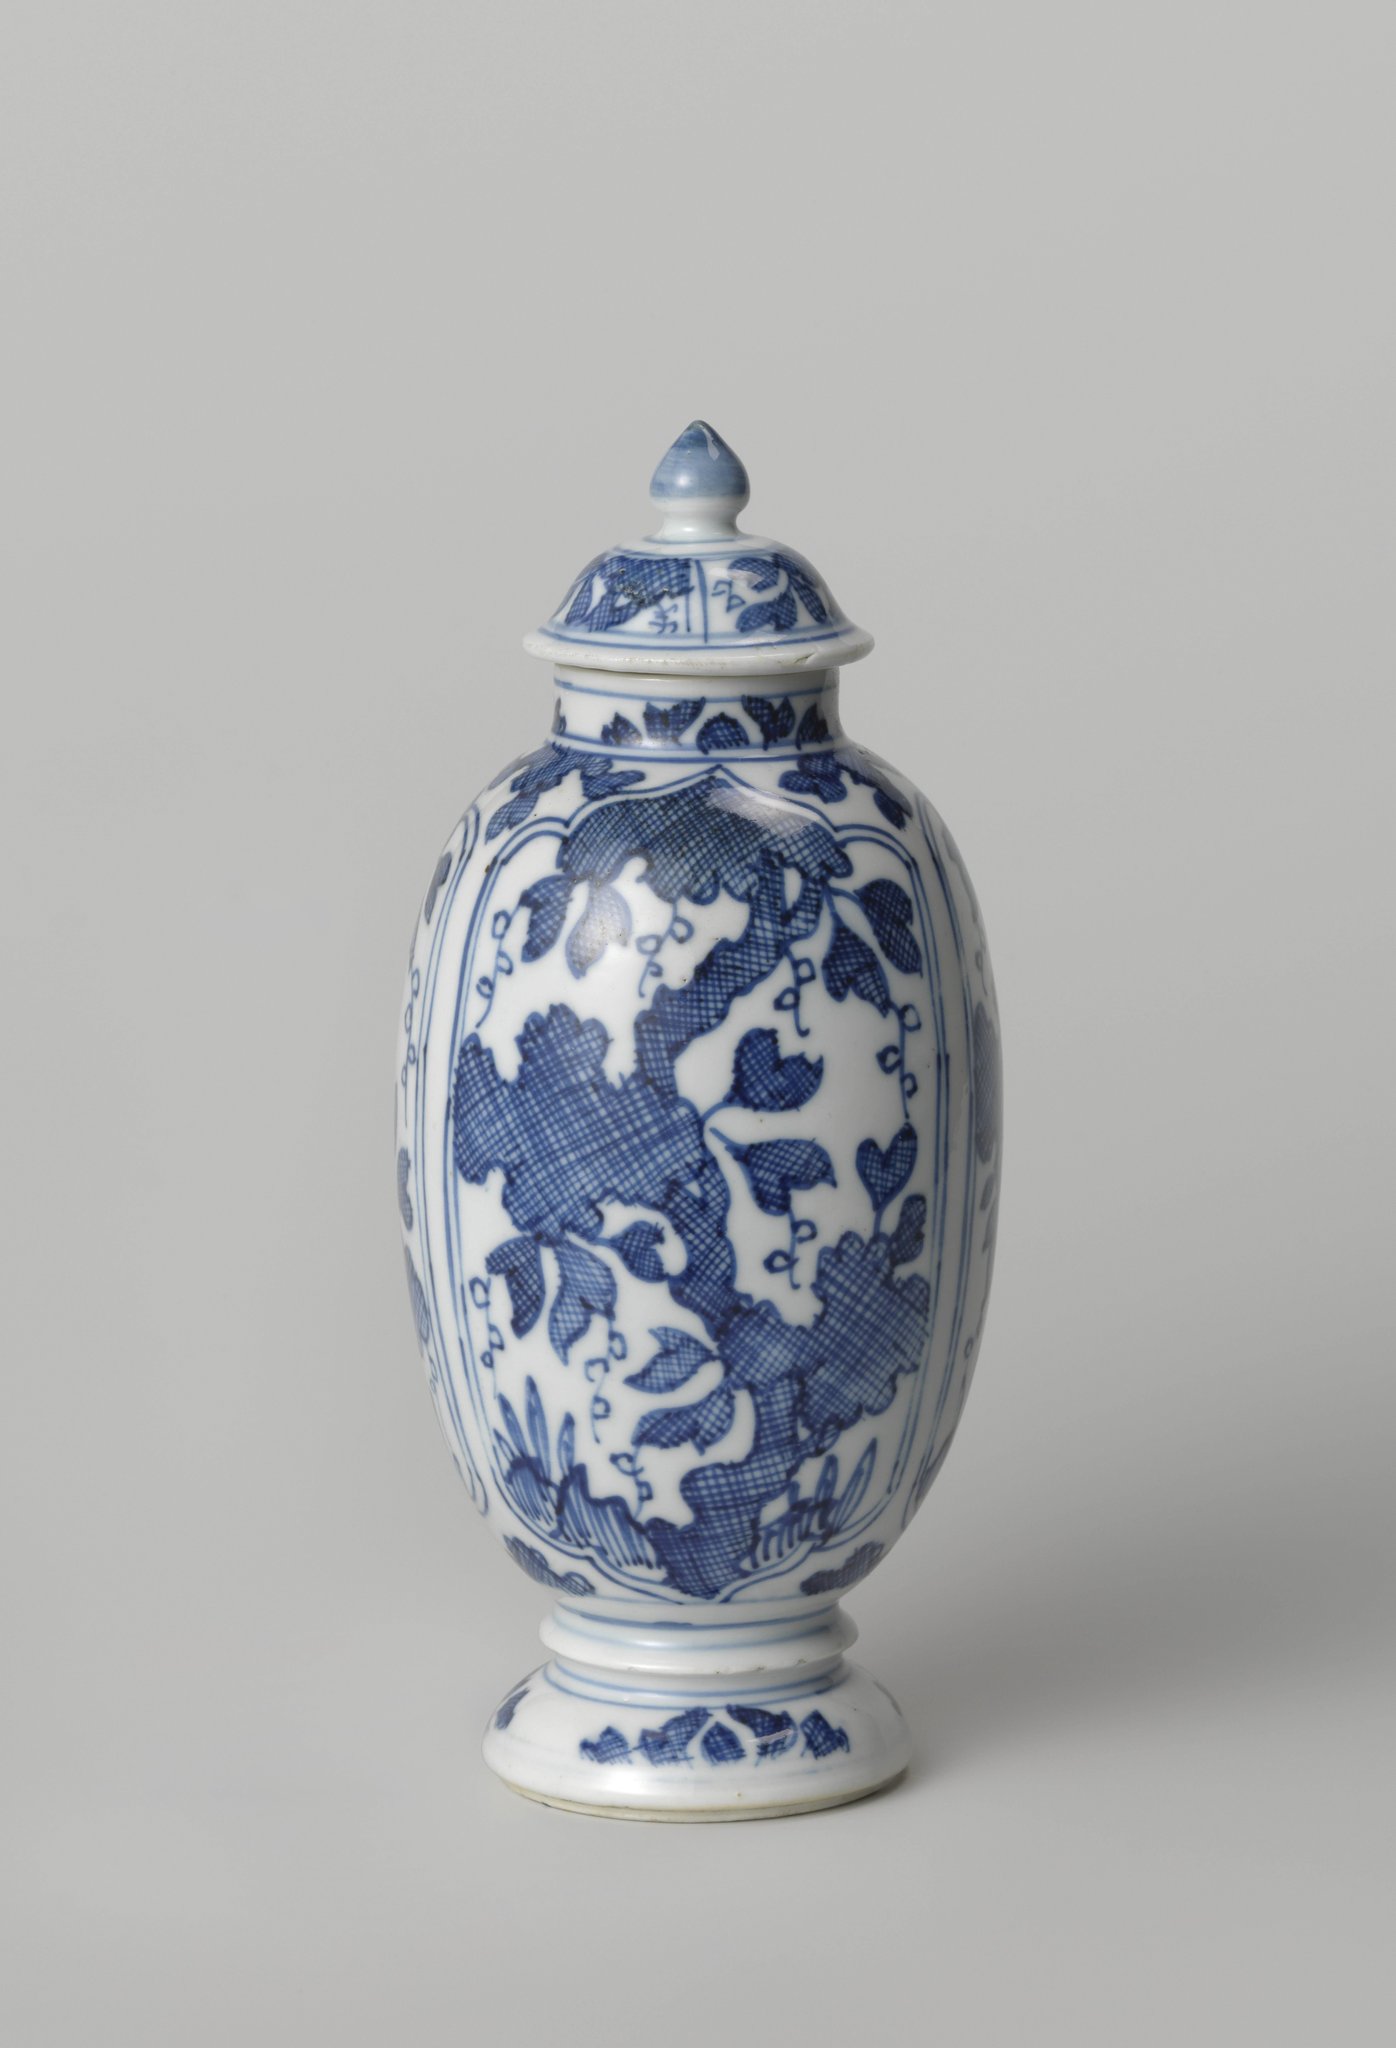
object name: covered jar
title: Covered jar with hatched plants in petal-shaped panels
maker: Anonymous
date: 1680-1720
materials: cobalt, glaze, paint, porcelain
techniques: firing, turning, vitrification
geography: china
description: Dekselpot van porselein met een uitgerekt, bolvormig lichaam en een hoge, spreidende voet, beschilderd in onderglazuur blauw. Op de wand langwerpige, bloembladvormige vakken met daarin bloeiende planten aangezet met arceerwerk; tussen de vakken langs de rand en de voet telkens een halve bloem. De rand en de voet met driemaal een gestileerde bloem. De deksel met dezelfde decoratie. Blauw-wit.